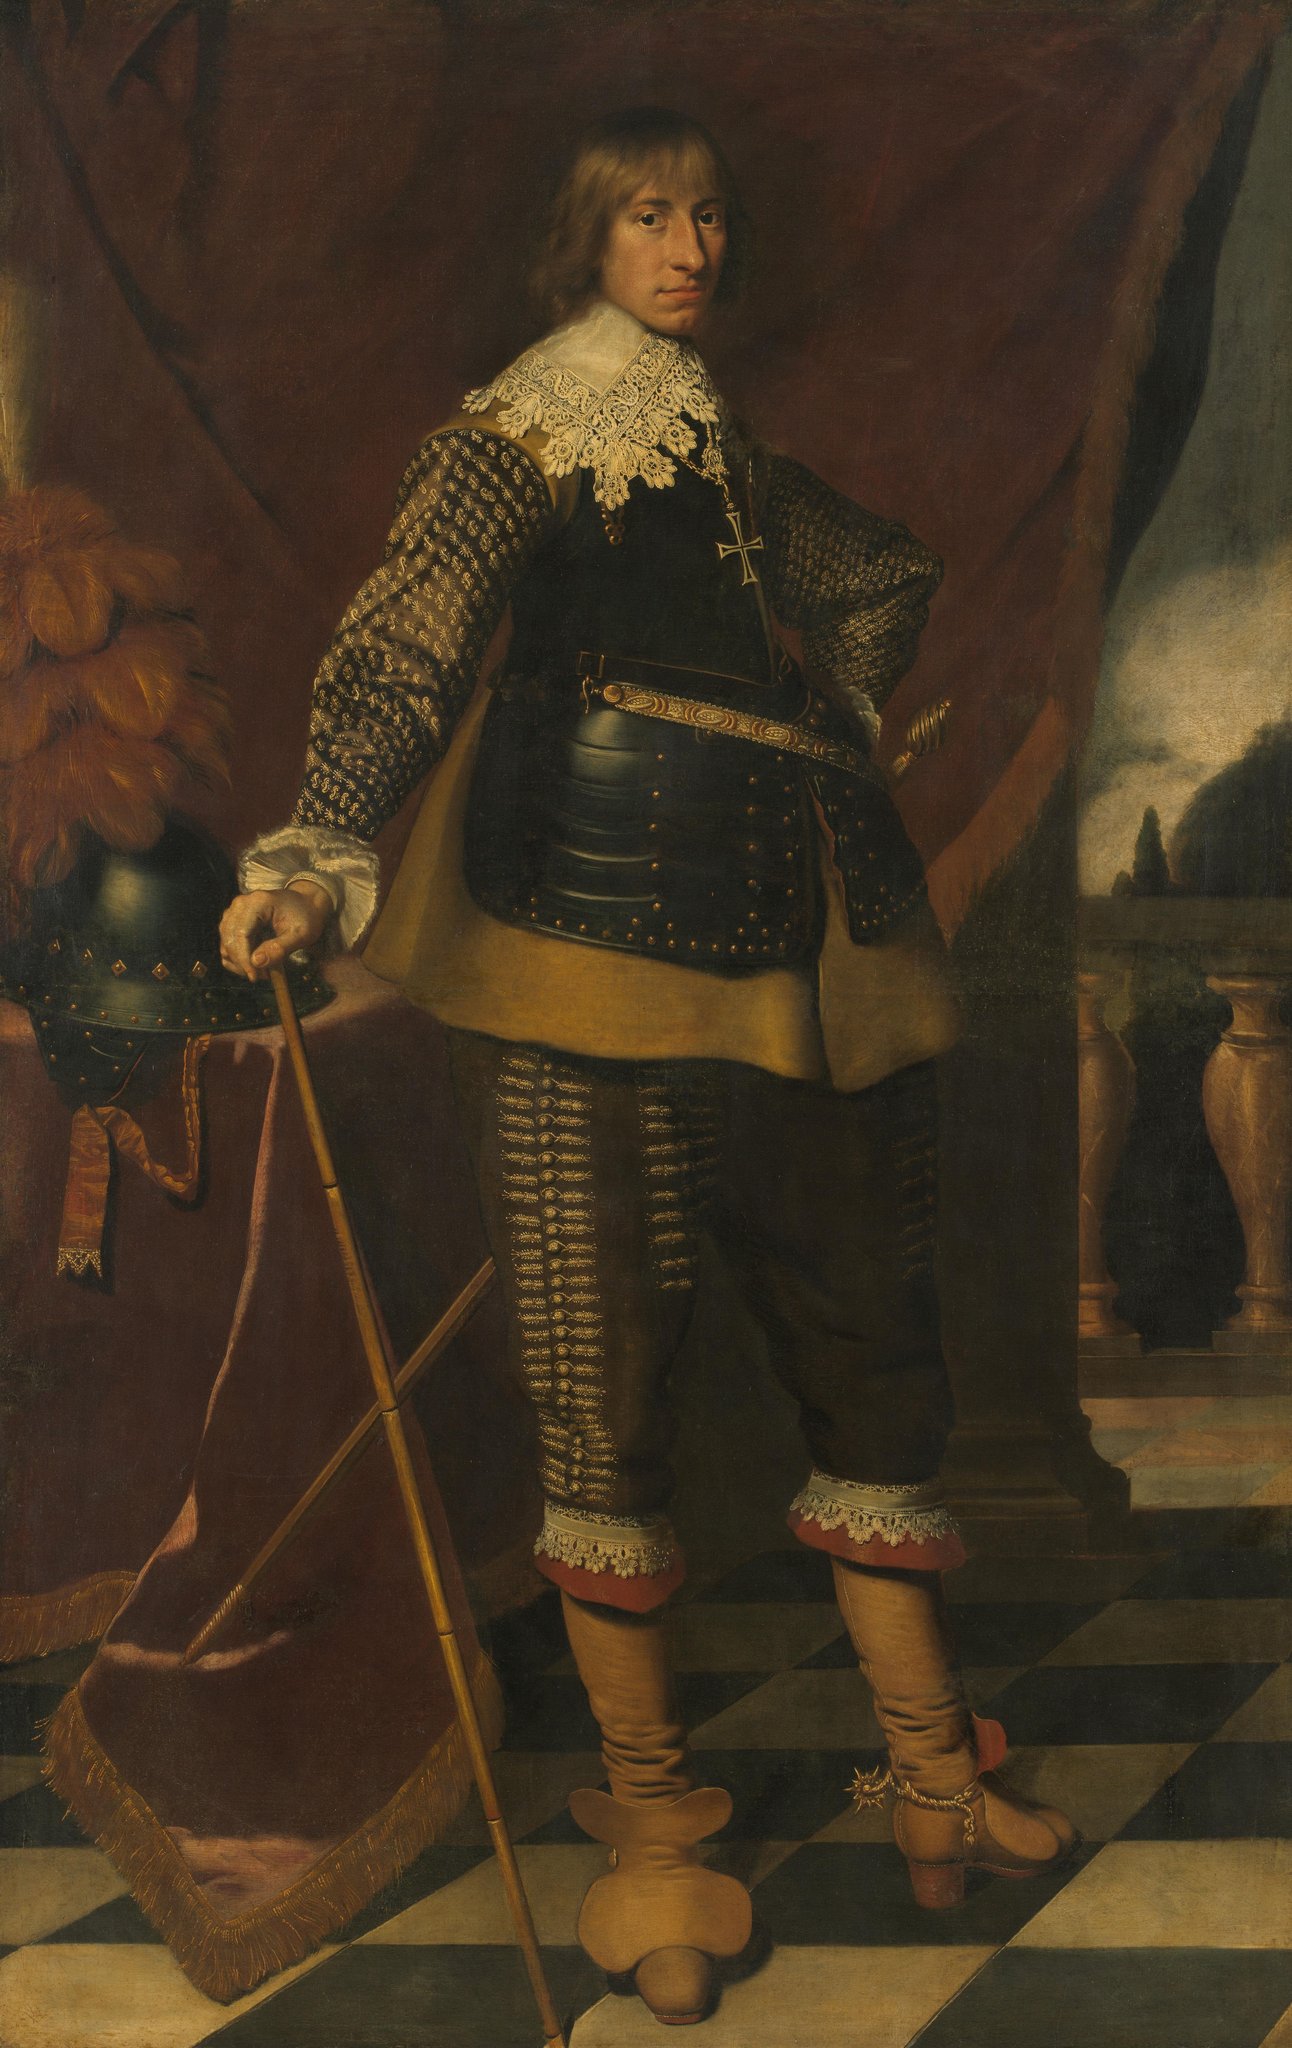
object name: painting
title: Portrait of Henry Casimir I (1612-40), Count of Nassau-Dietz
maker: wybrand de geest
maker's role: draughtsman, painter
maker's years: 1592-1665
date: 1632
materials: canvas, oil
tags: arnhem, hendrik casimir i graaf van nassau-dietz, historical persons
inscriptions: signature, on the lower edge of the balustrade: ‘V D Geest ƒ’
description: Portret van Hendrik Casimir I, graaf van Nassau-Dietz, stadhouder van Friesland, landcommandeur van de balije Utrecht. Staande ten voeten uit met de stadhoudersstaf in de rechterhand. Links een helm met pluimen op een tafeltje, rechts een balustrade.